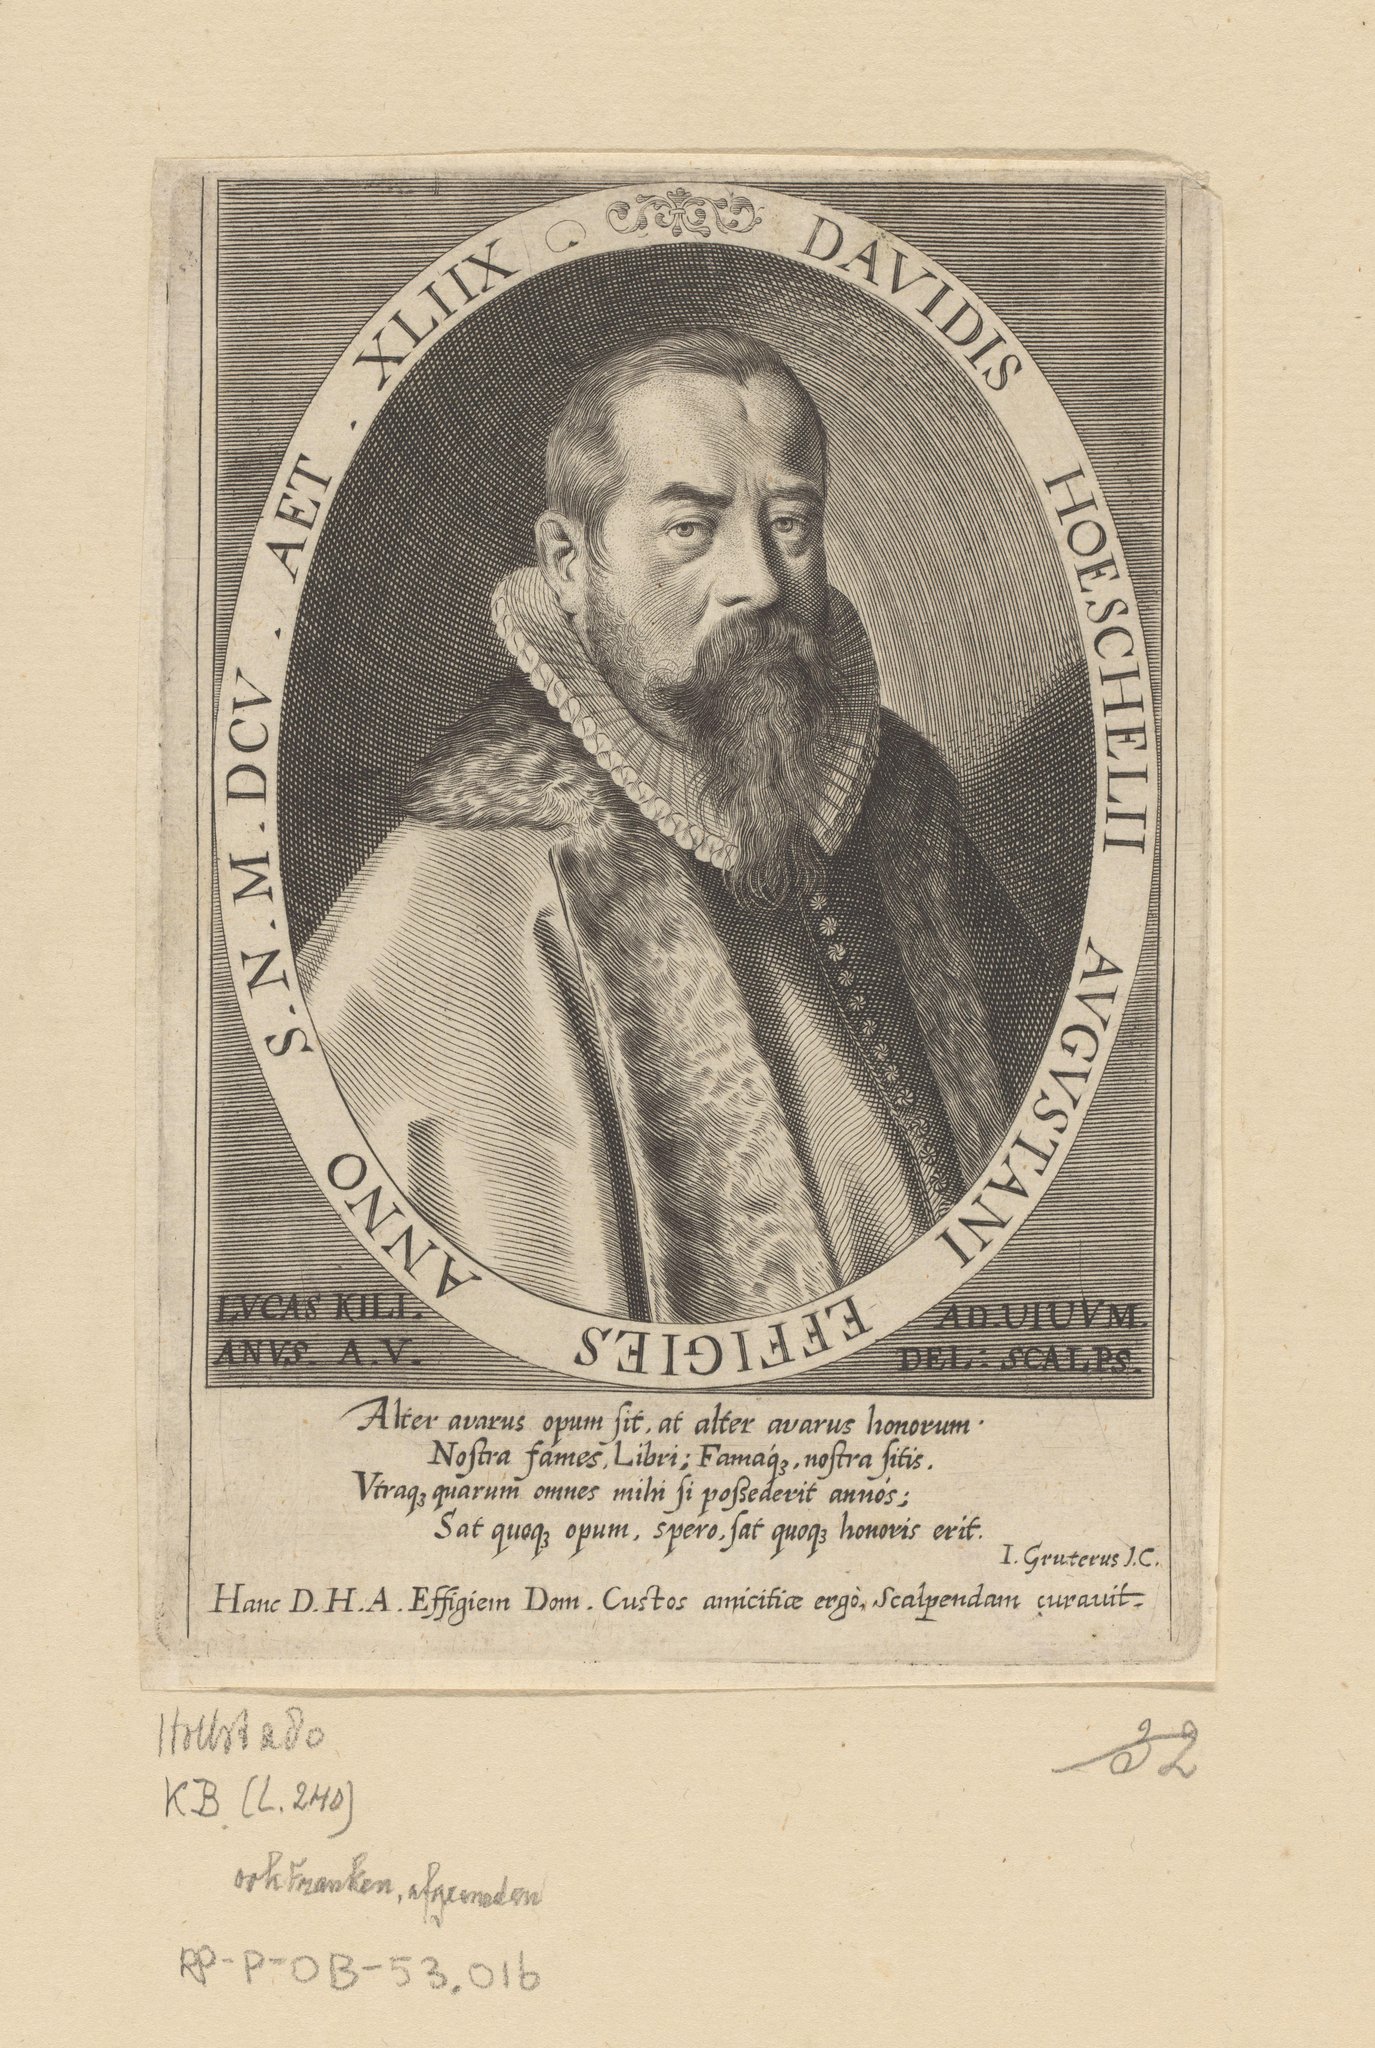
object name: print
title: Portret van David Höschel op 48-jarige leeftijd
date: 1604-1615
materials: paper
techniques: engraving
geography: augsburg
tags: augsburg, philology (+ portrait of scholar, scientist), further education (+ portrait of teacher, professor), historical persons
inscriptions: collector's mark: Lugt 240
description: Tekst in het Latijn in de omlijsting, in de ondermarge.